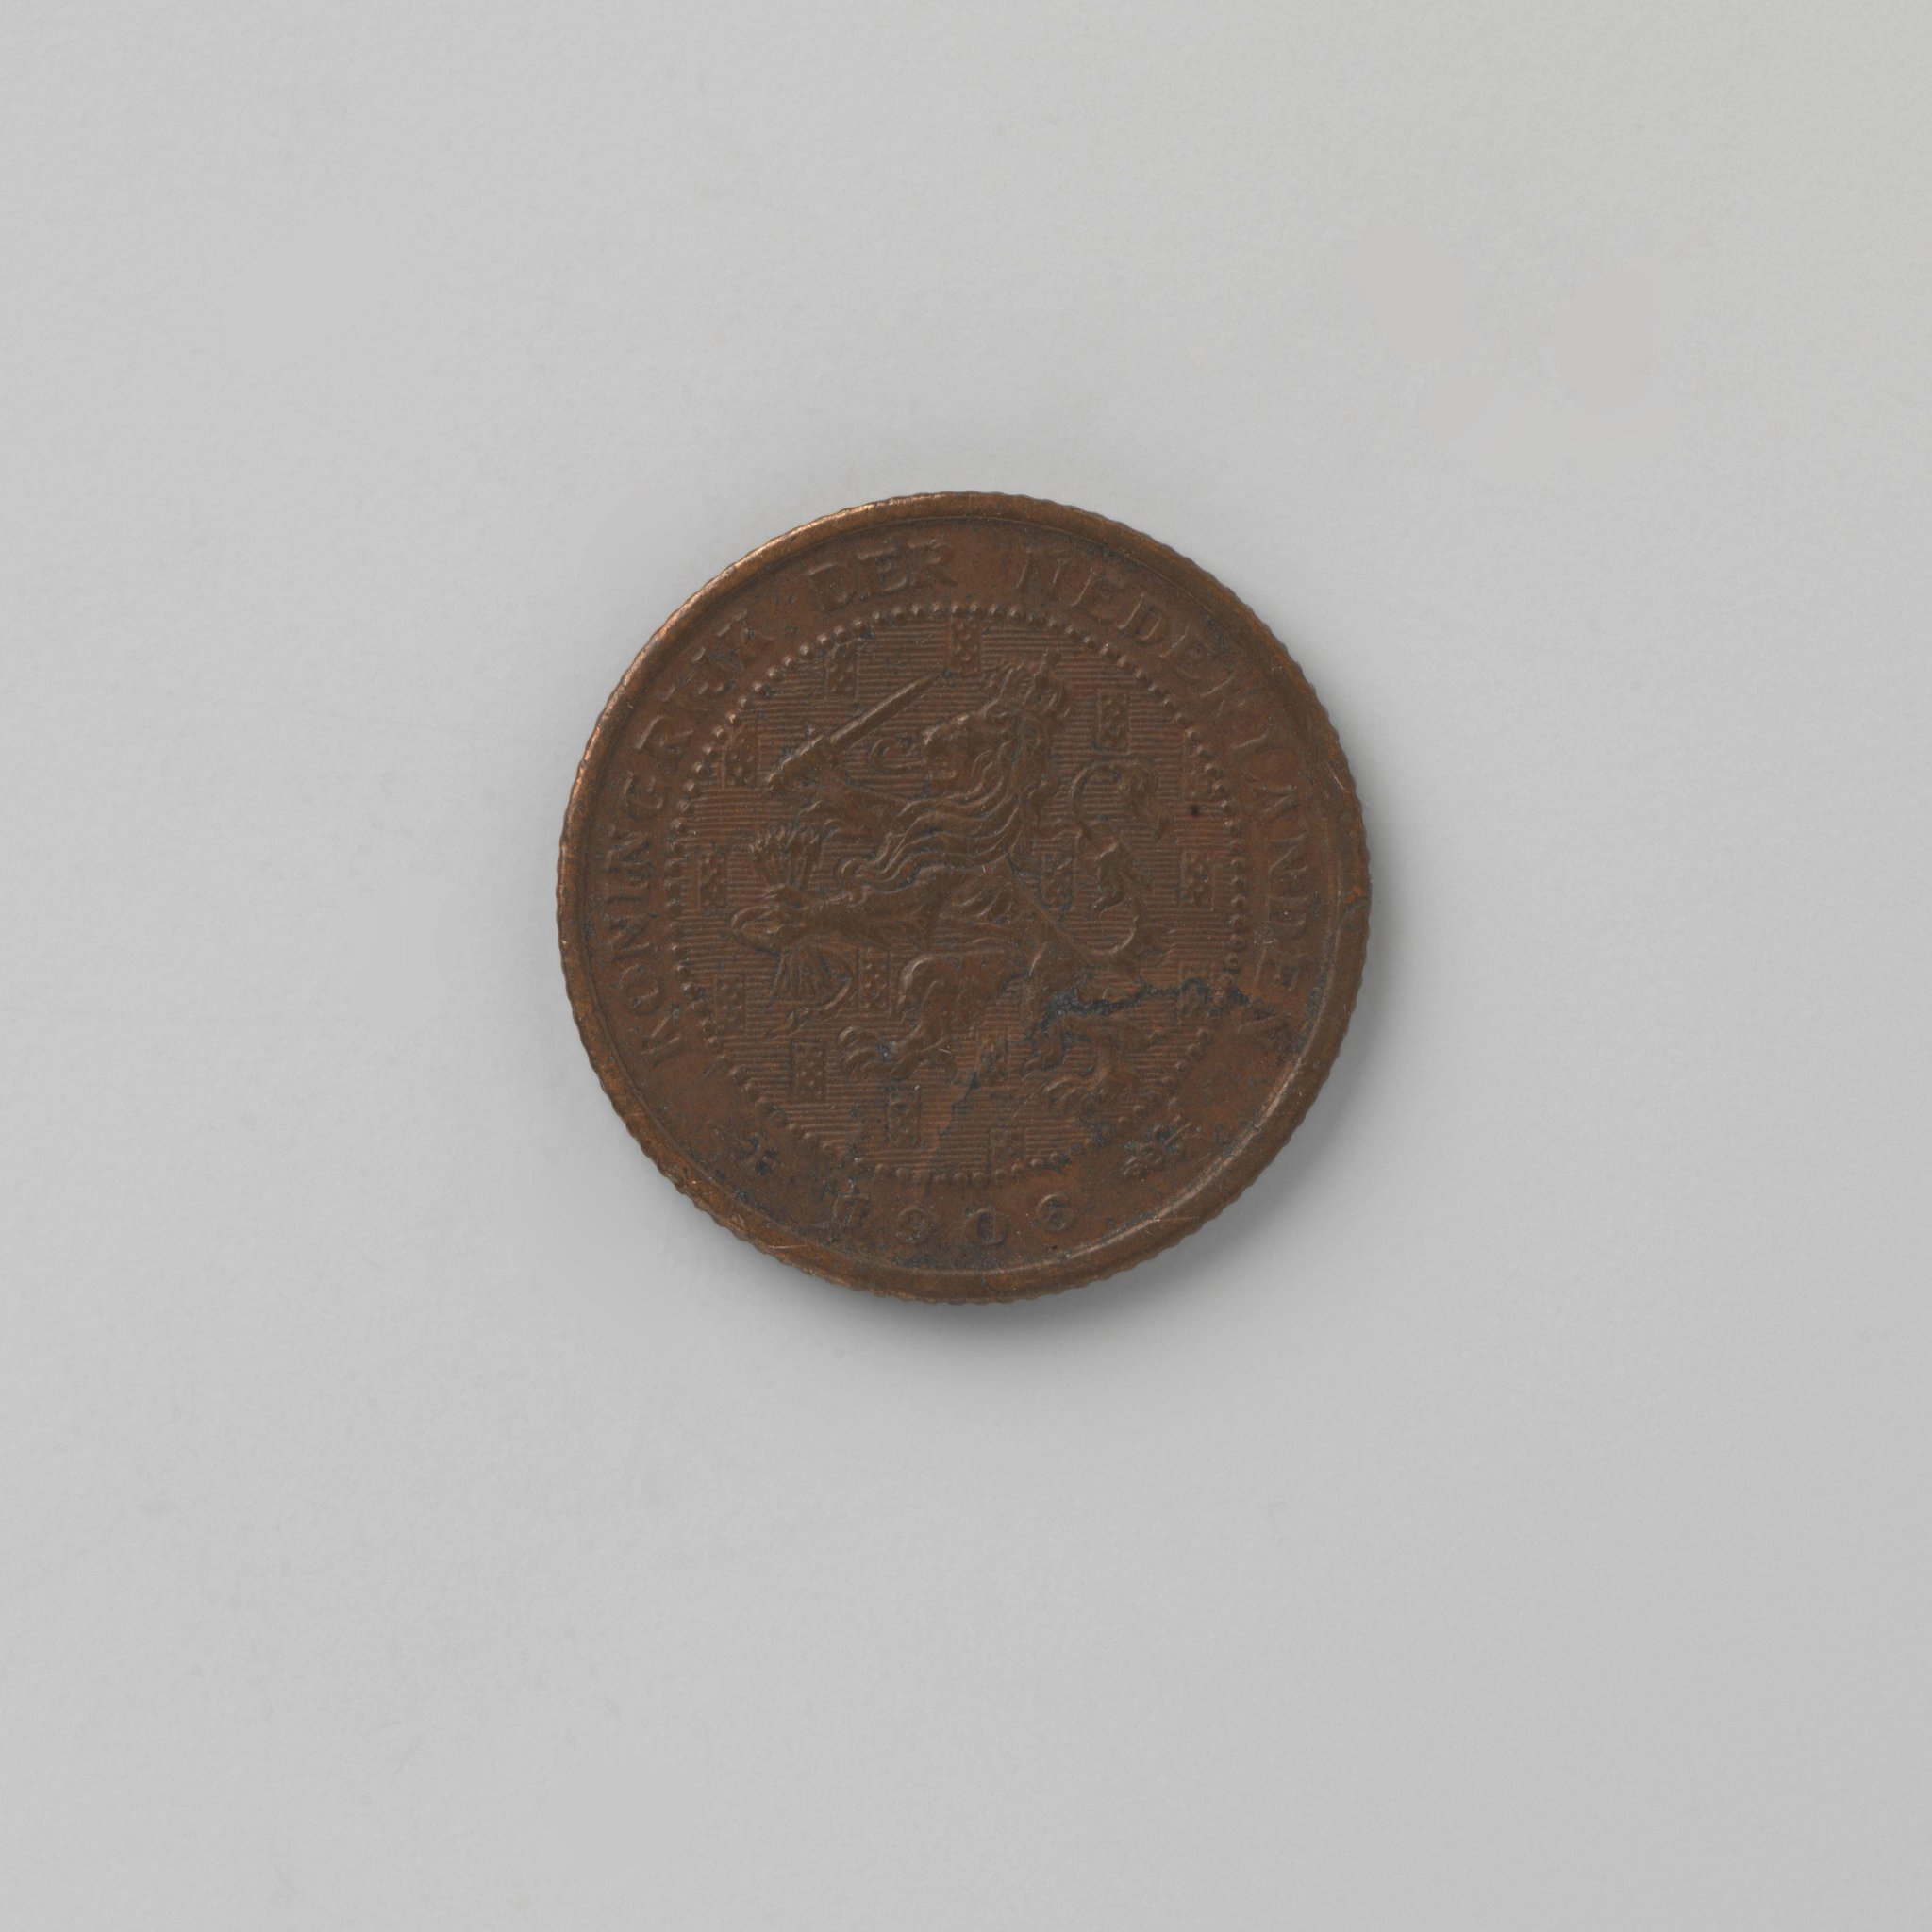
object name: coin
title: Nederland, ½ cent,1906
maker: wilhelmina of the netherlands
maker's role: print maker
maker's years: 1880-1962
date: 1906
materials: bronze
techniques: striking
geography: utrecht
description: Bronzen munt. Voorzijde: in een veld rijkswapen. Jaartal onderaan in omschrift. Keerzijde: binnen twee samengebonden oranjetakken waarde-aanduiding ½ cent. Kartelrand.